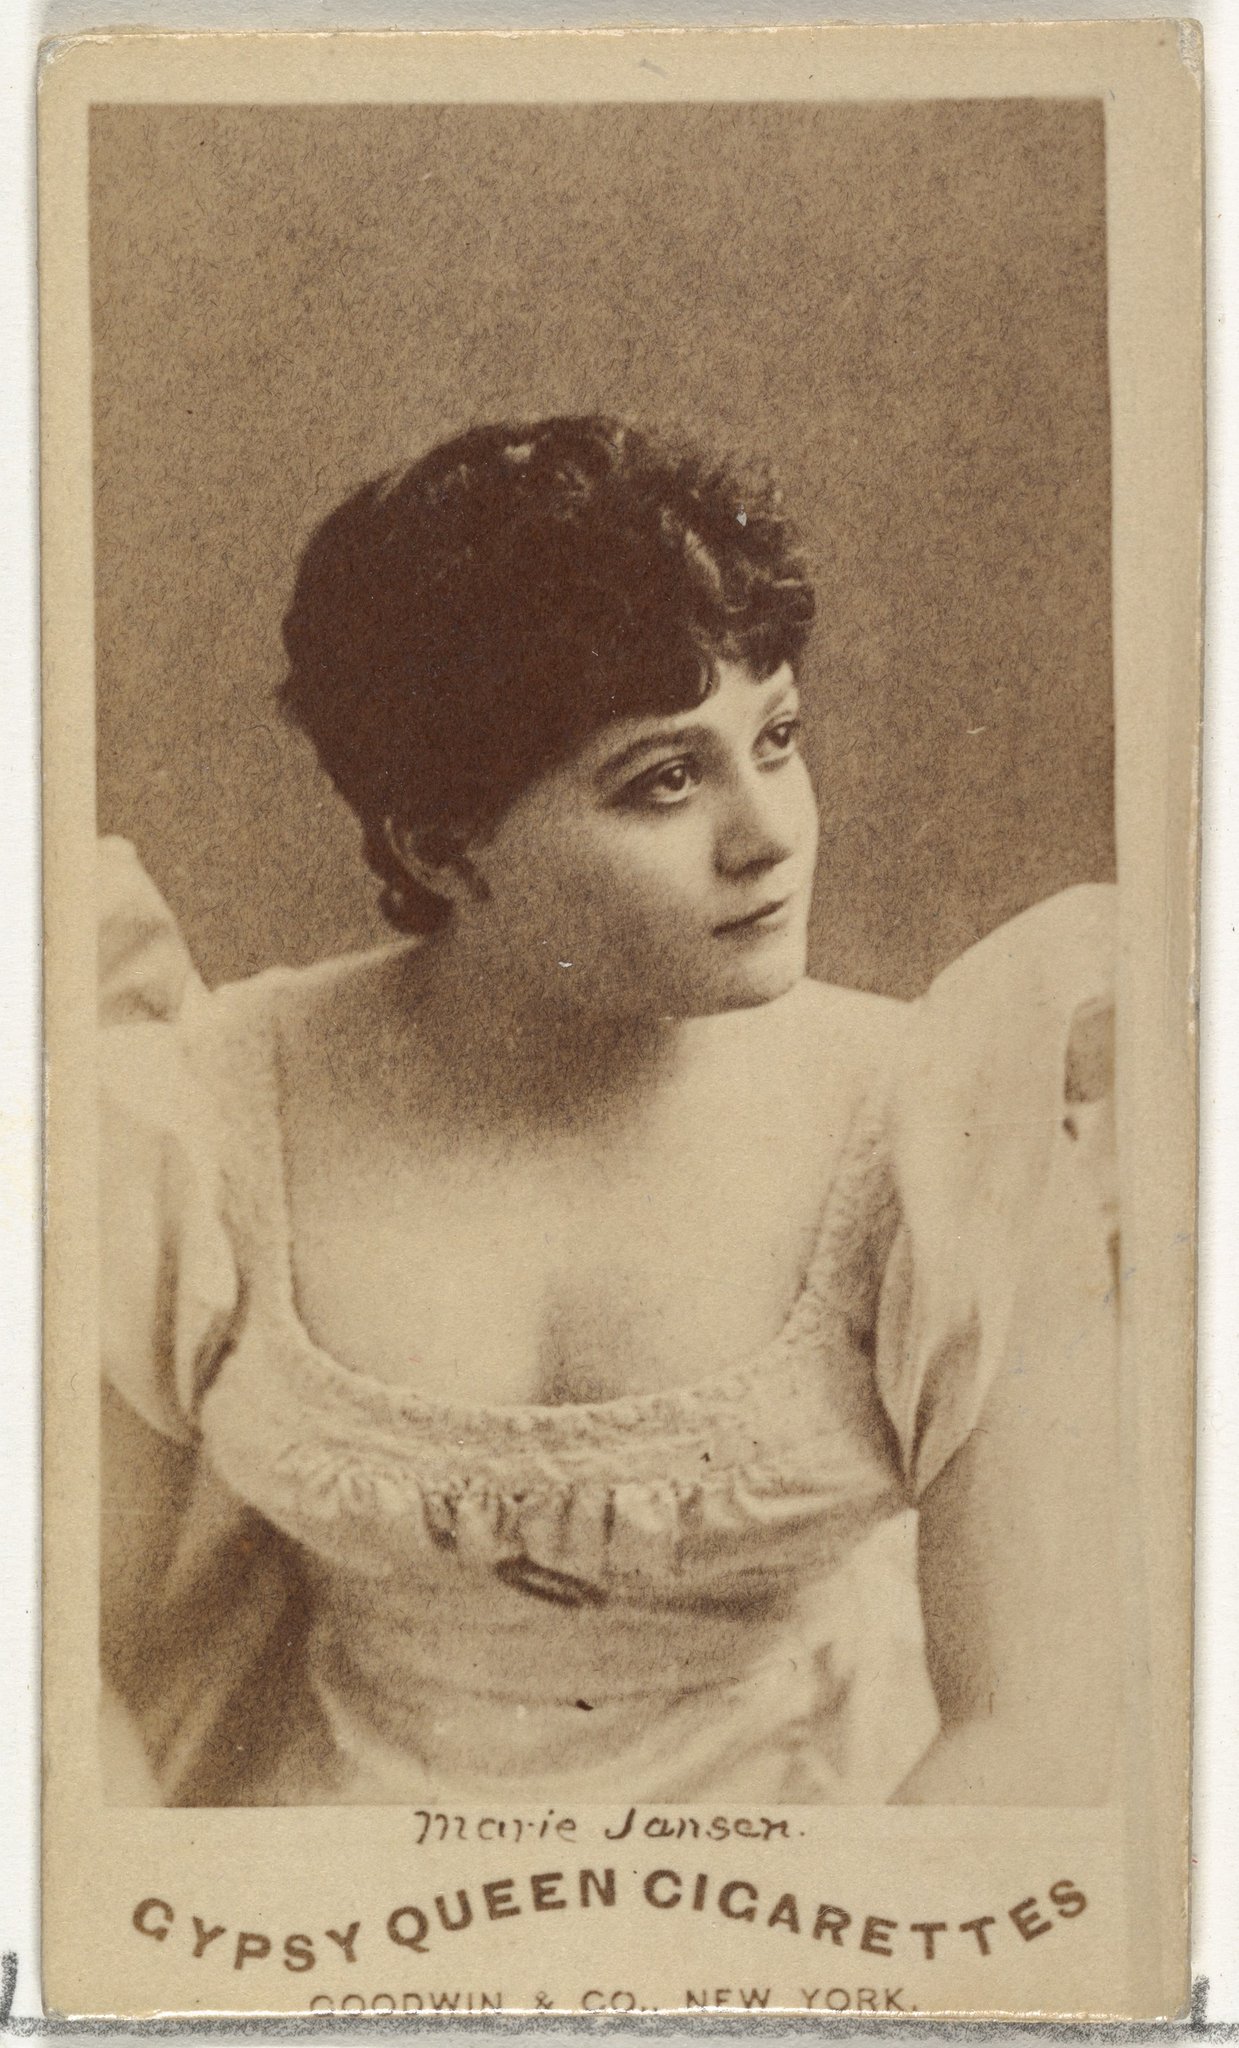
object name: photograph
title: Marie Jansen, from the Actors and Actresses series (N171) for Gypsy Queen Cigarettes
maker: goodwin & company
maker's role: publisher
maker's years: 1850-1950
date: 1886-1890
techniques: albumen silver print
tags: portraits,women,actresses